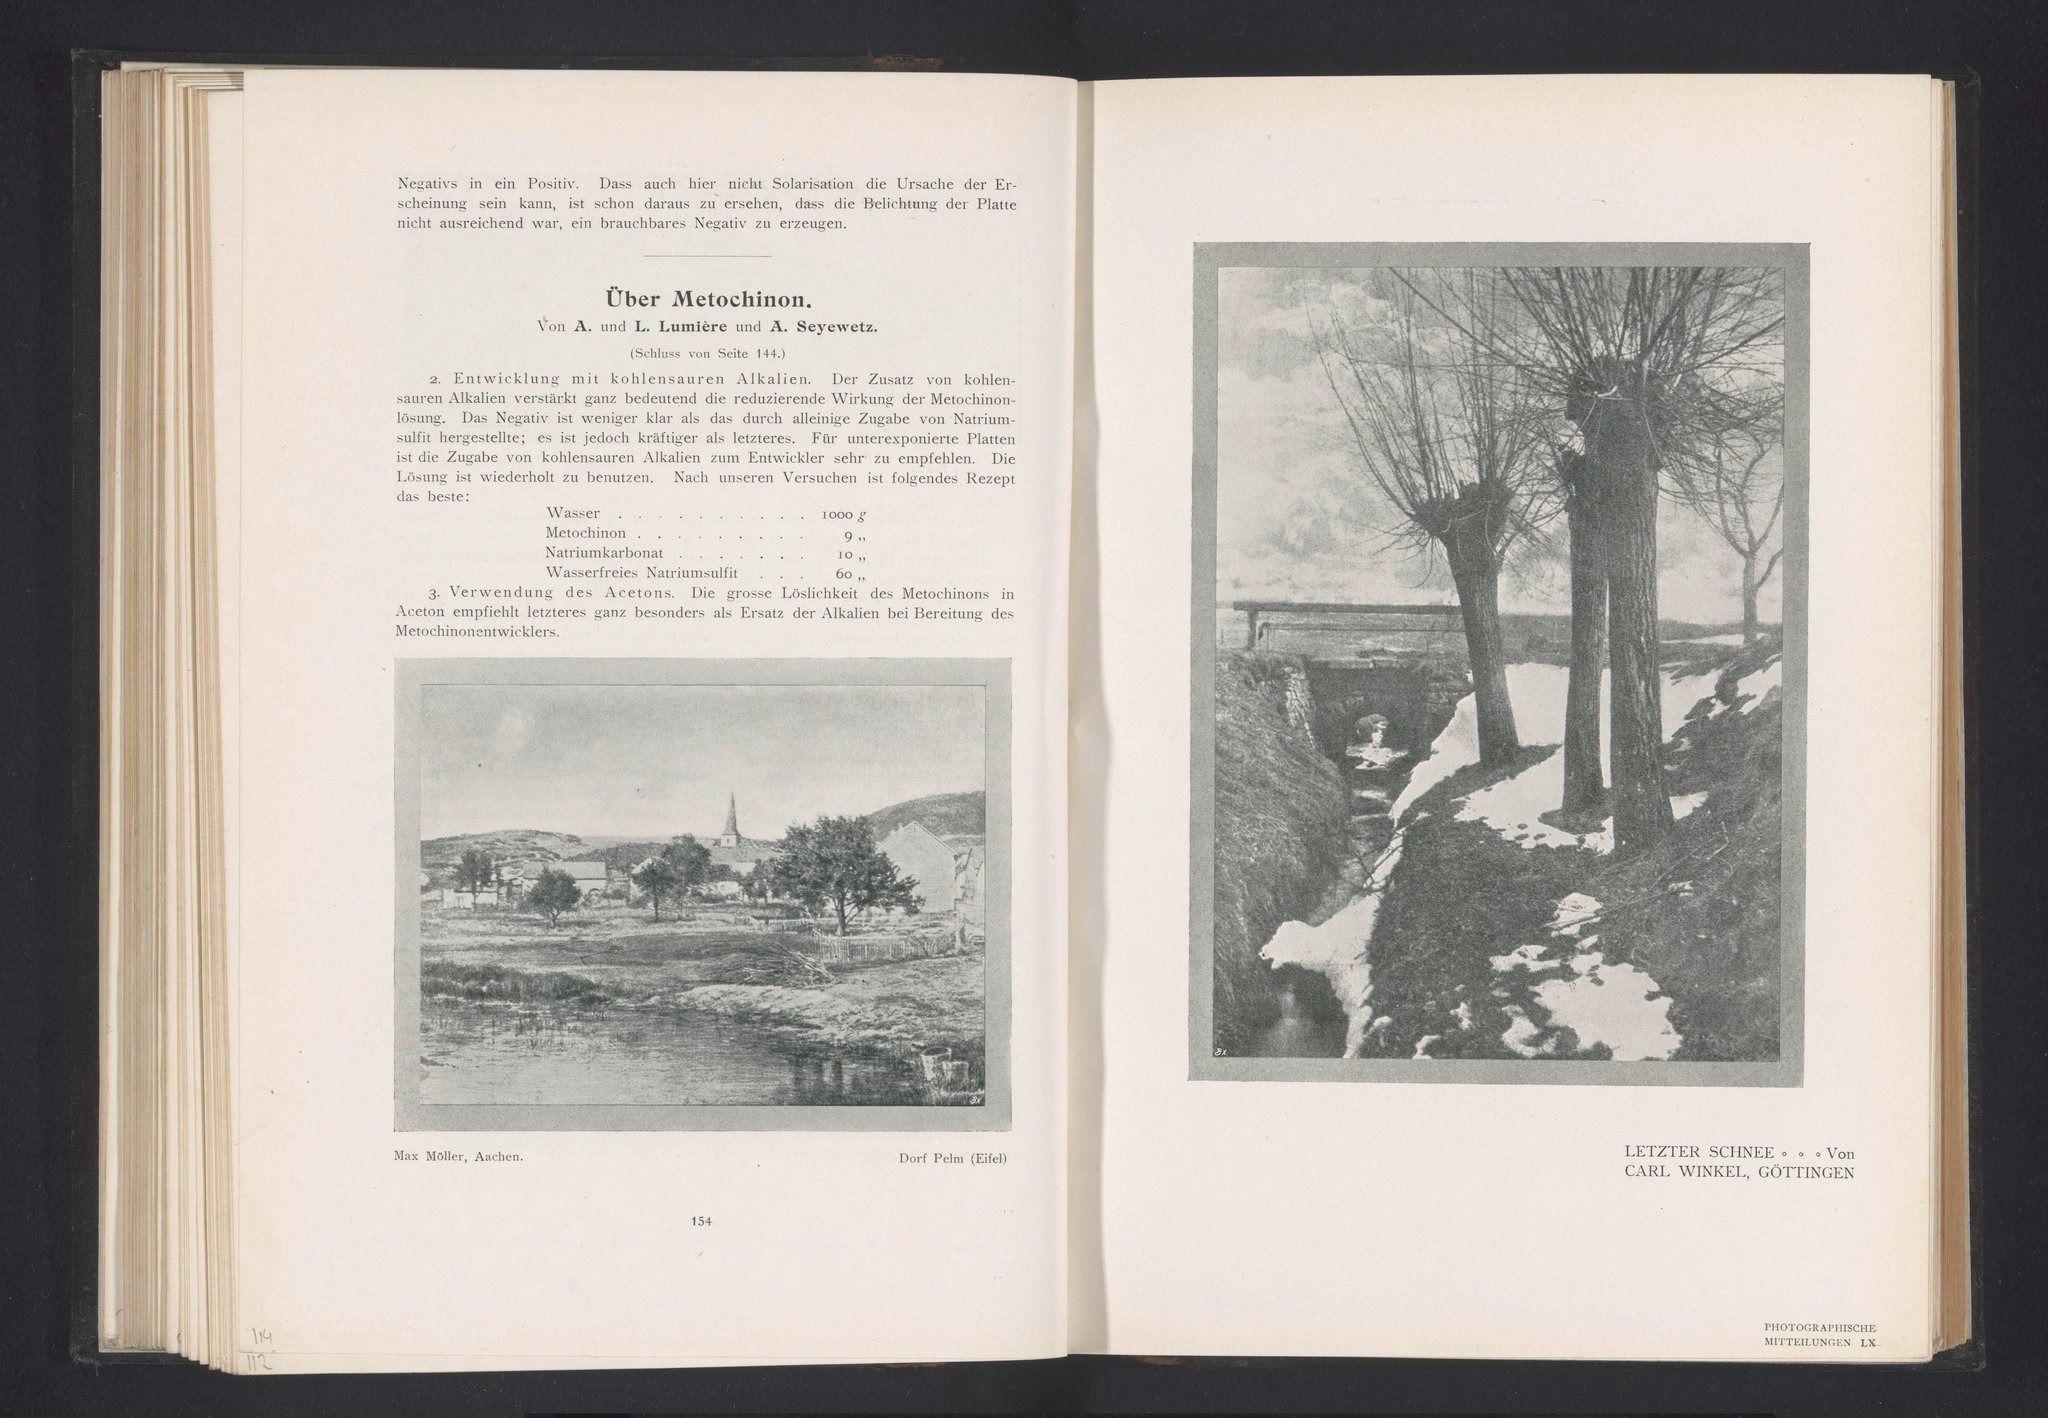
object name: page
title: Gezicht op Pelm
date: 1898-1903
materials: paper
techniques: autotype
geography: pelm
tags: villa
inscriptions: monogram: ‘BX’